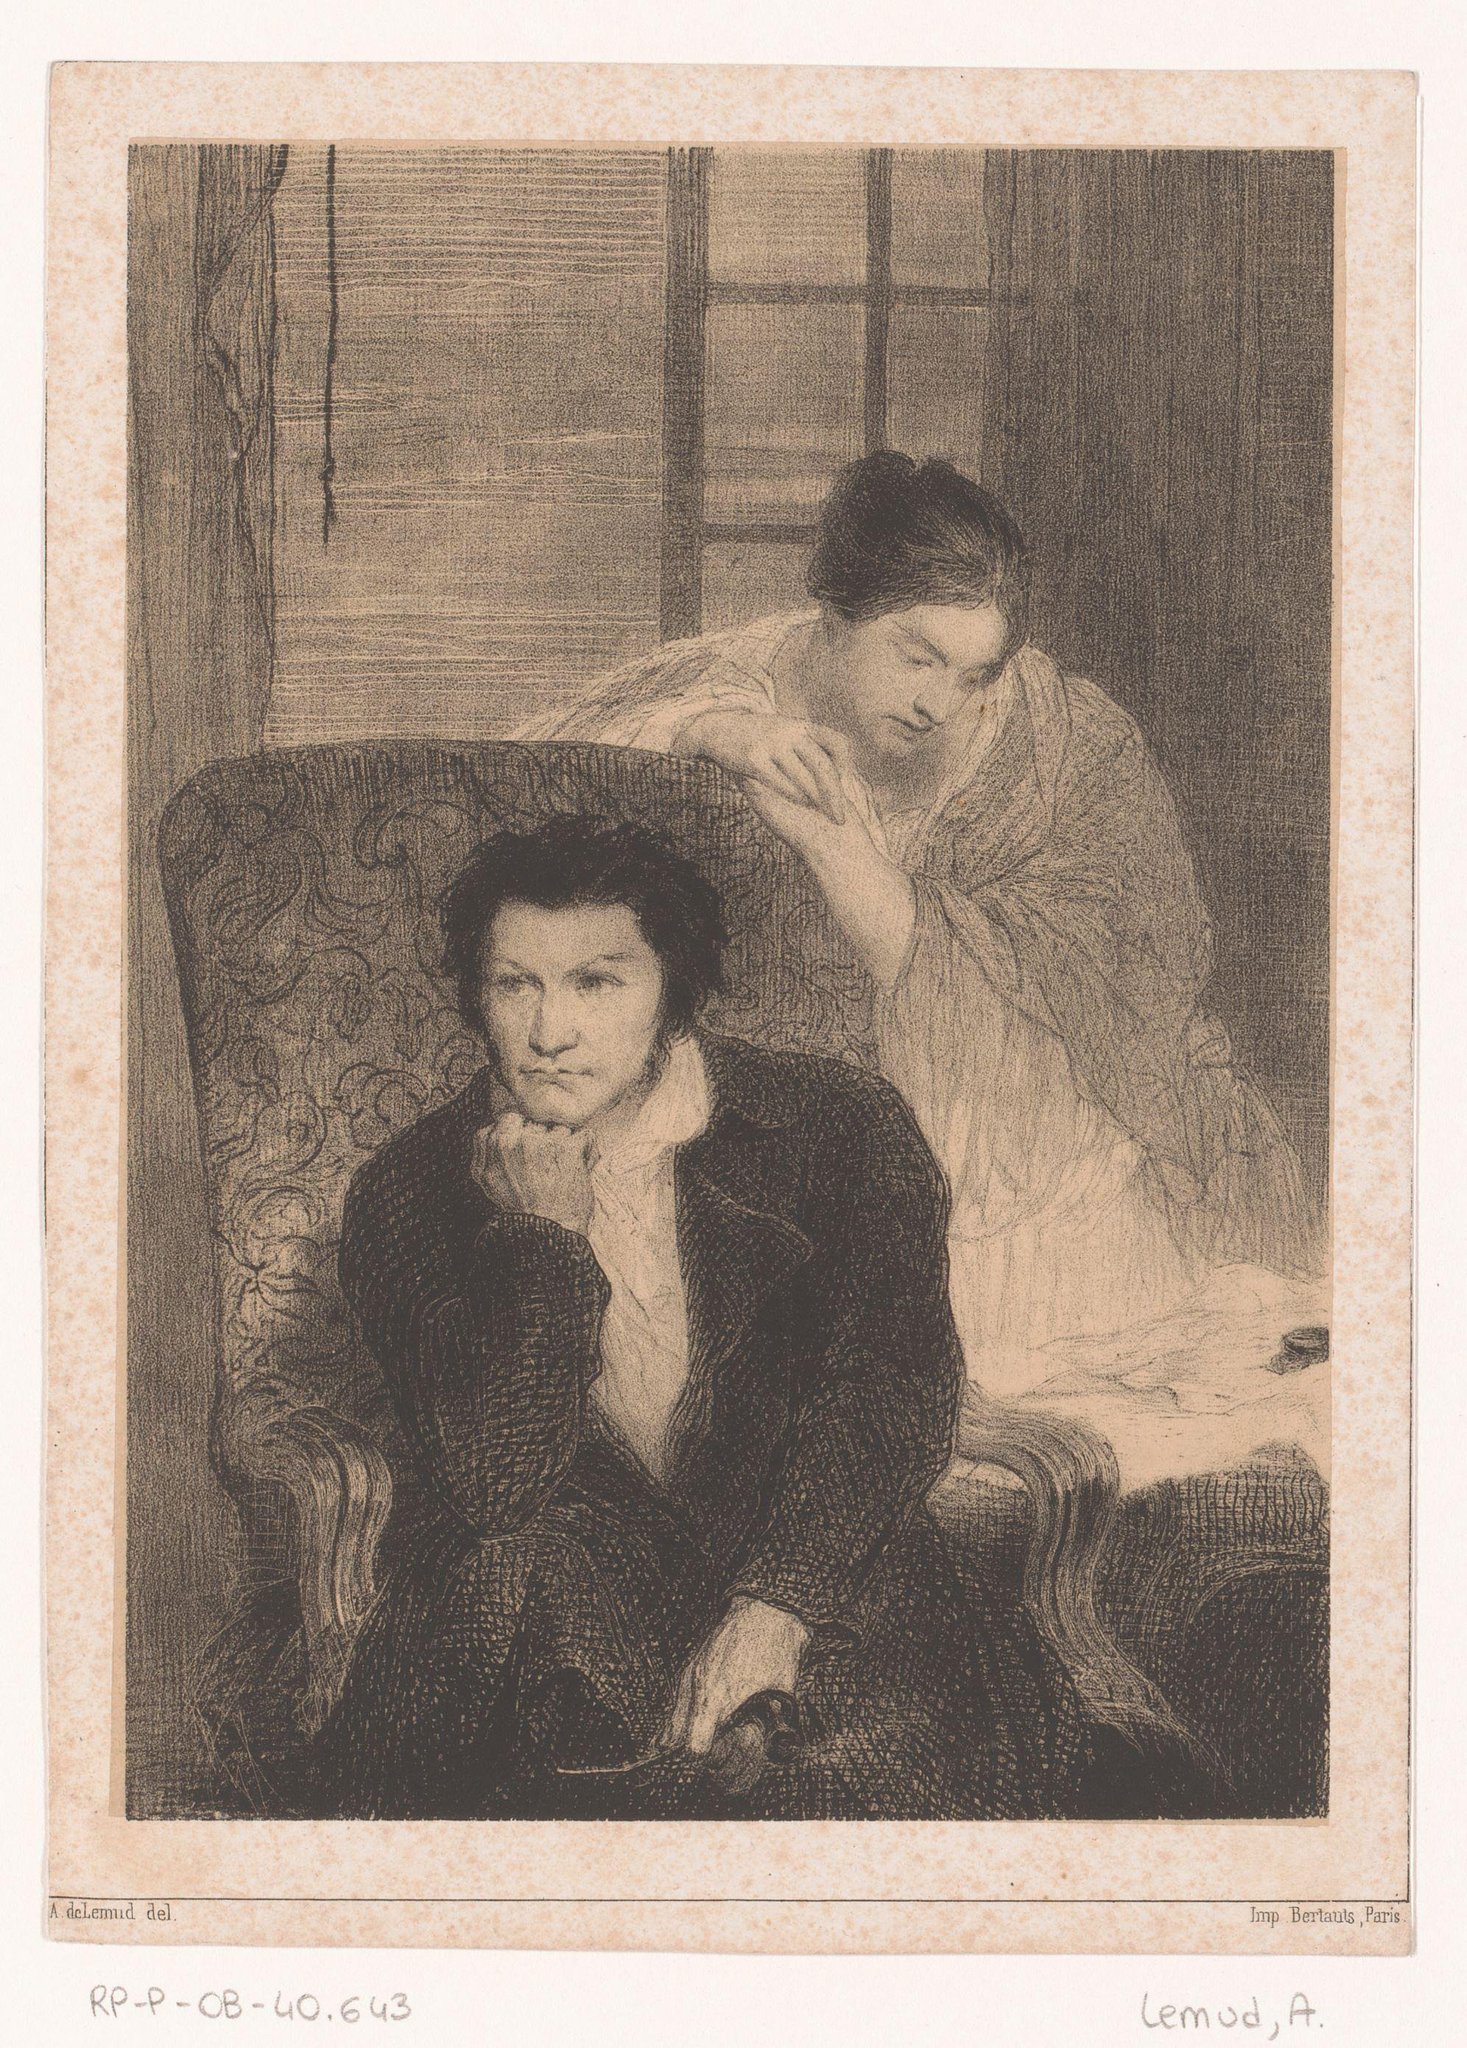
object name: print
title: Man in fauteuil met vrouw bij open raam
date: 1833-1881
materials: paper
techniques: lithography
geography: paris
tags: armchair, seat, standing figure - aa - female human figure, open window, head held in the hand(s), with elbows leaning on an elevation or on the knees, sitting on an elevation